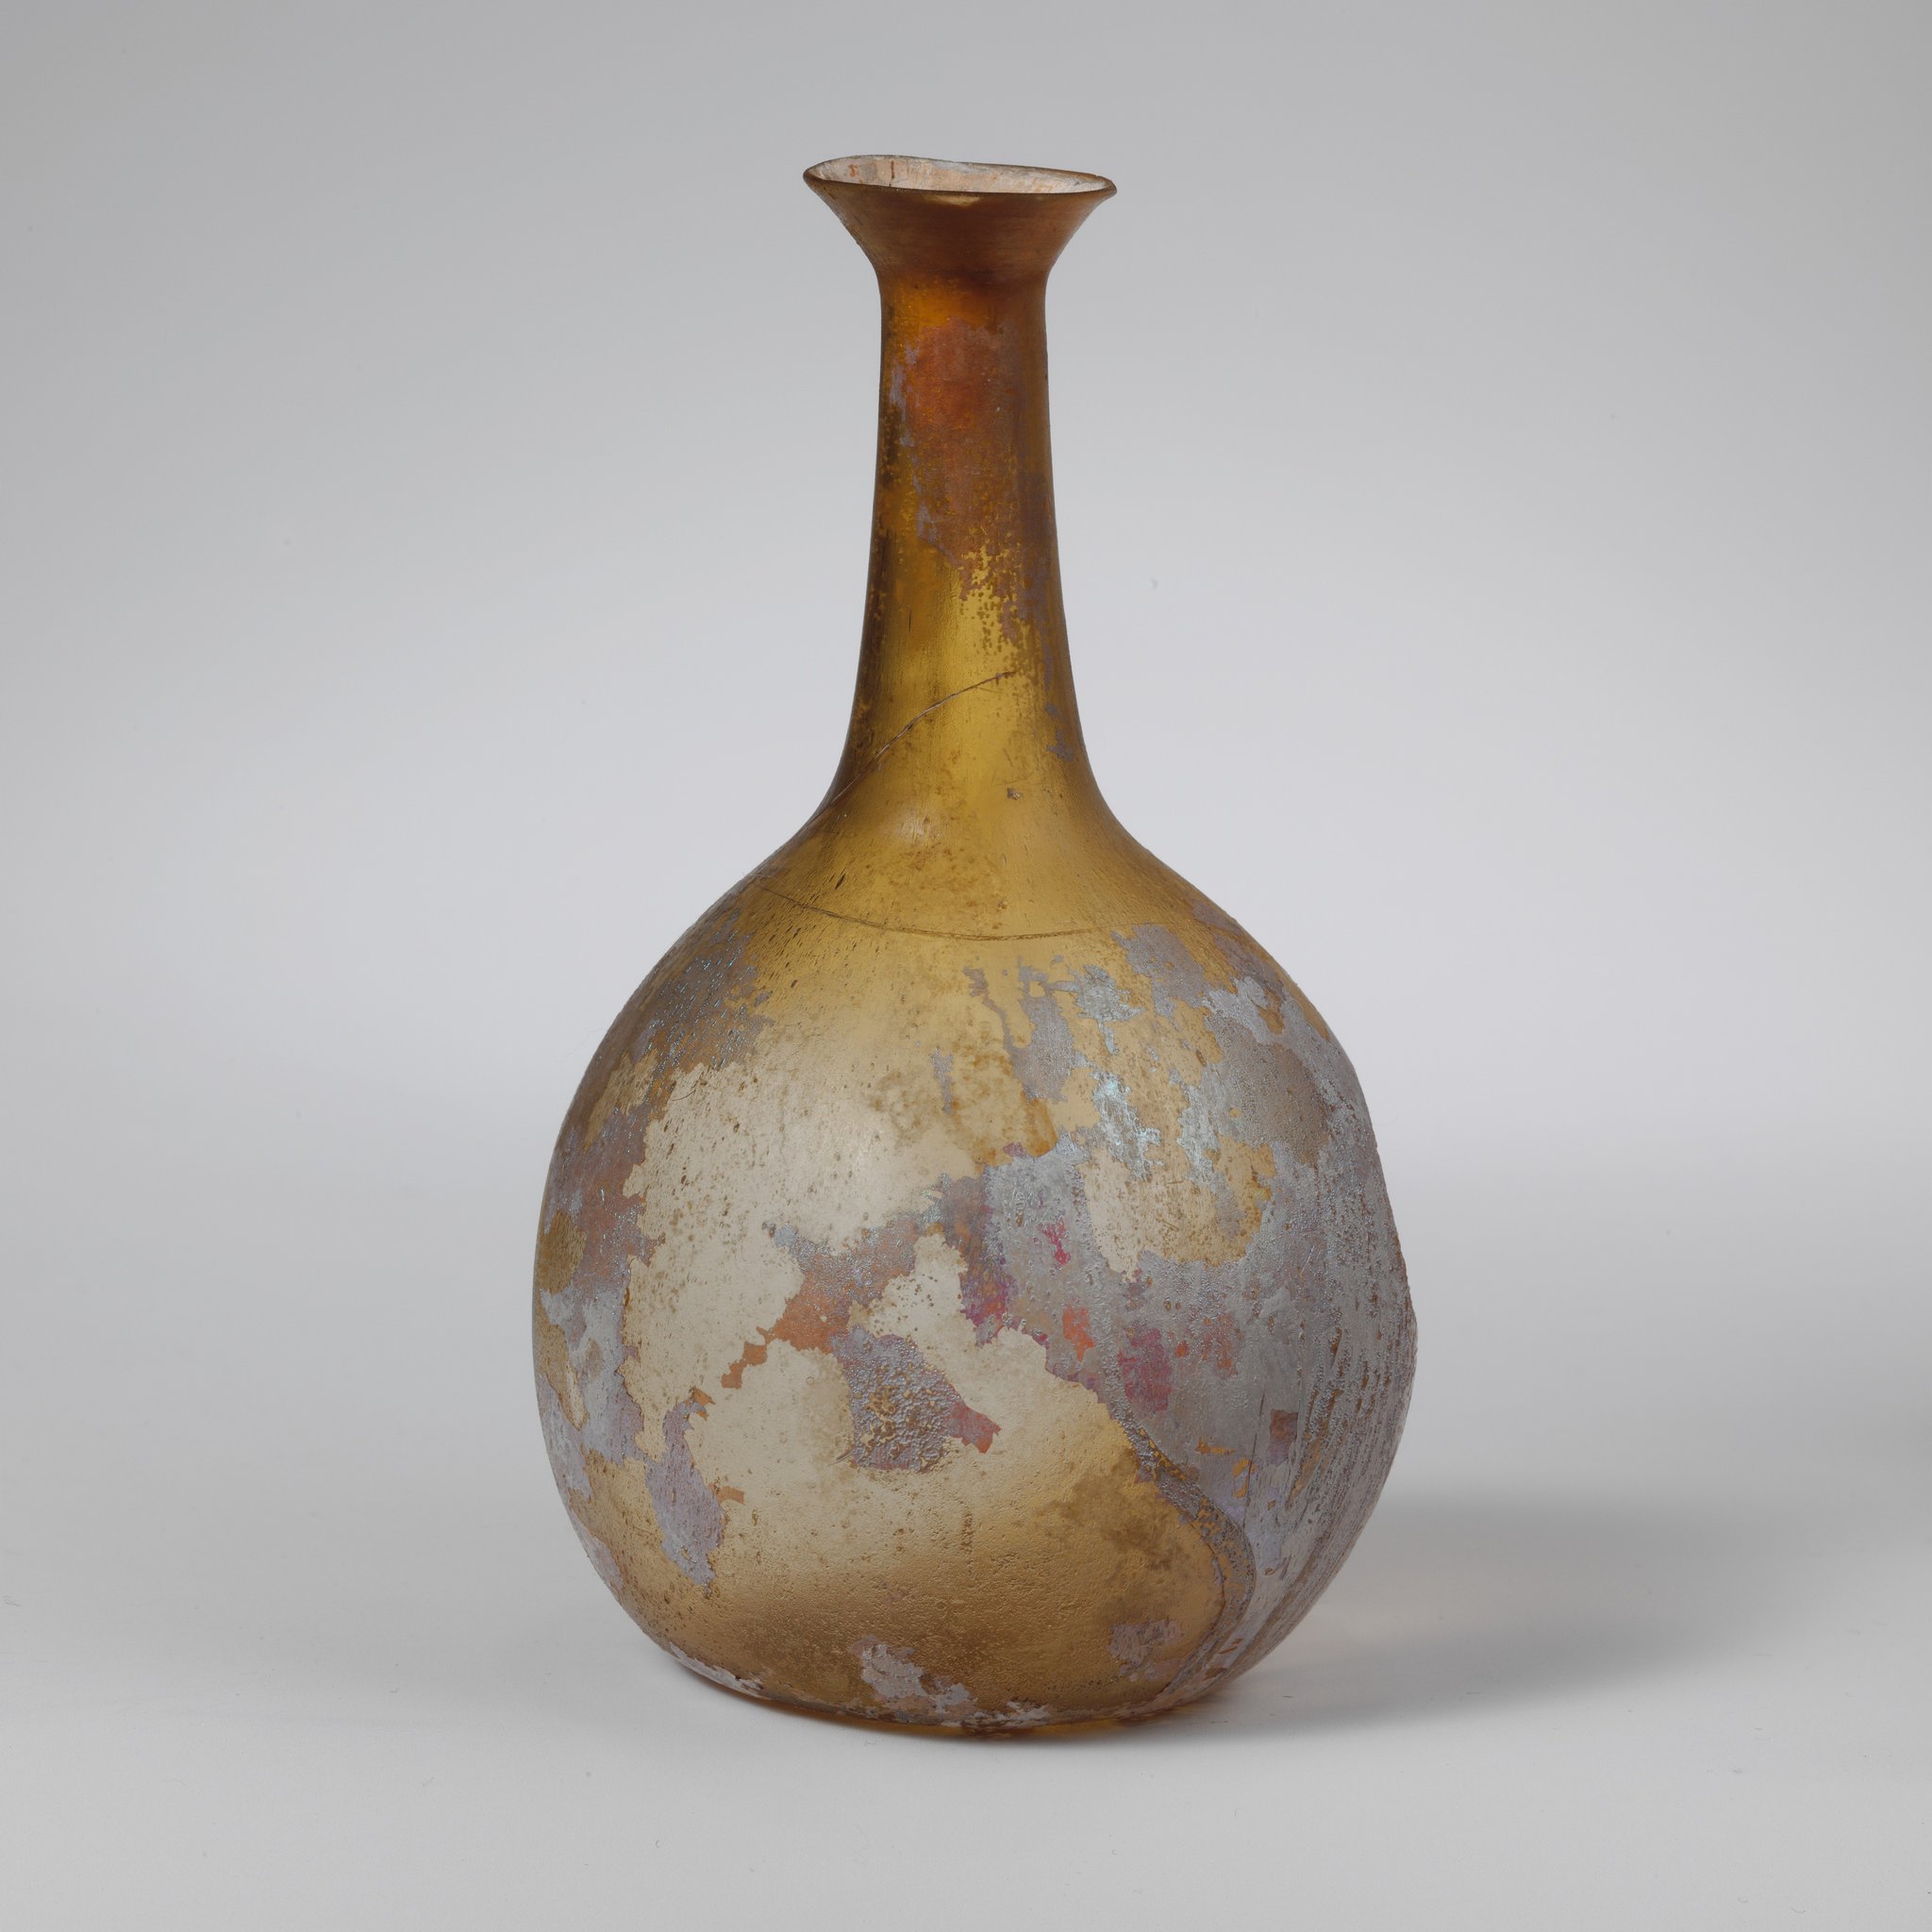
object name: perfume bottle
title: Glass perfume bottle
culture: roman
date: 1-100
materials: glass